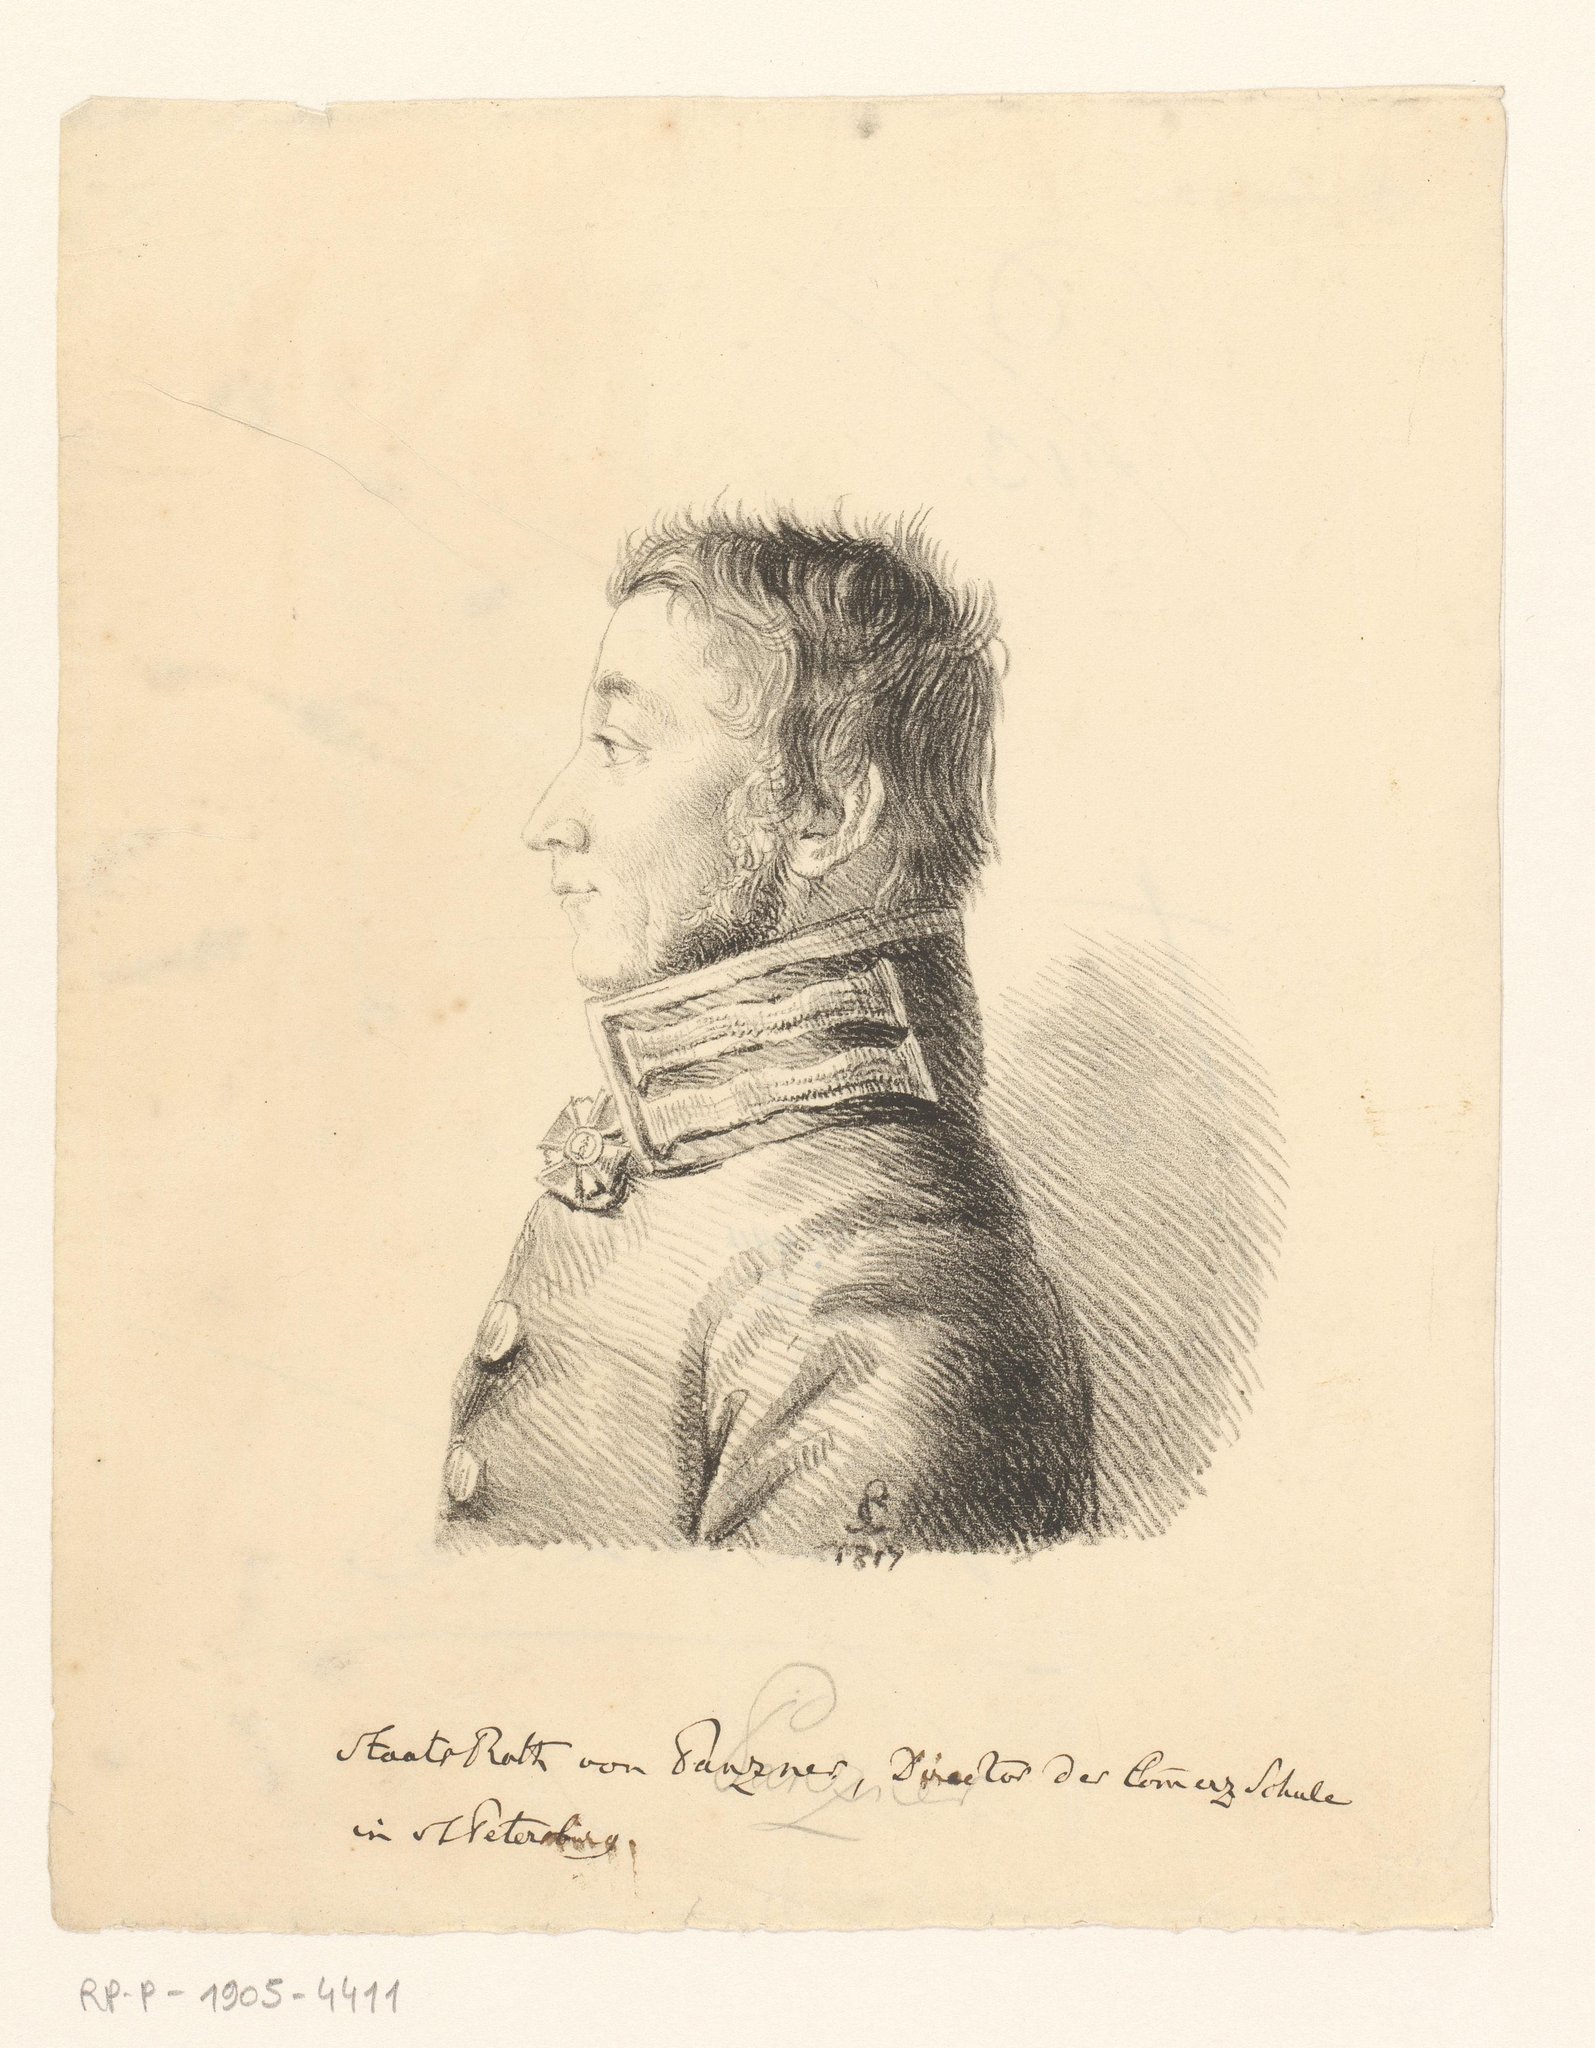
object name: print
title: Portret van een onbekende man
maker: Anonymous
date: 1817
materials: paper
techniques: lithograph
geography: eastern europe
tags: adult man, historical persons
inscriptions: monogram: ‘CL’, inscription: ‘Staats Rath von Danzner [...] Schule in [...].’, collector's mark: Lugt 2228